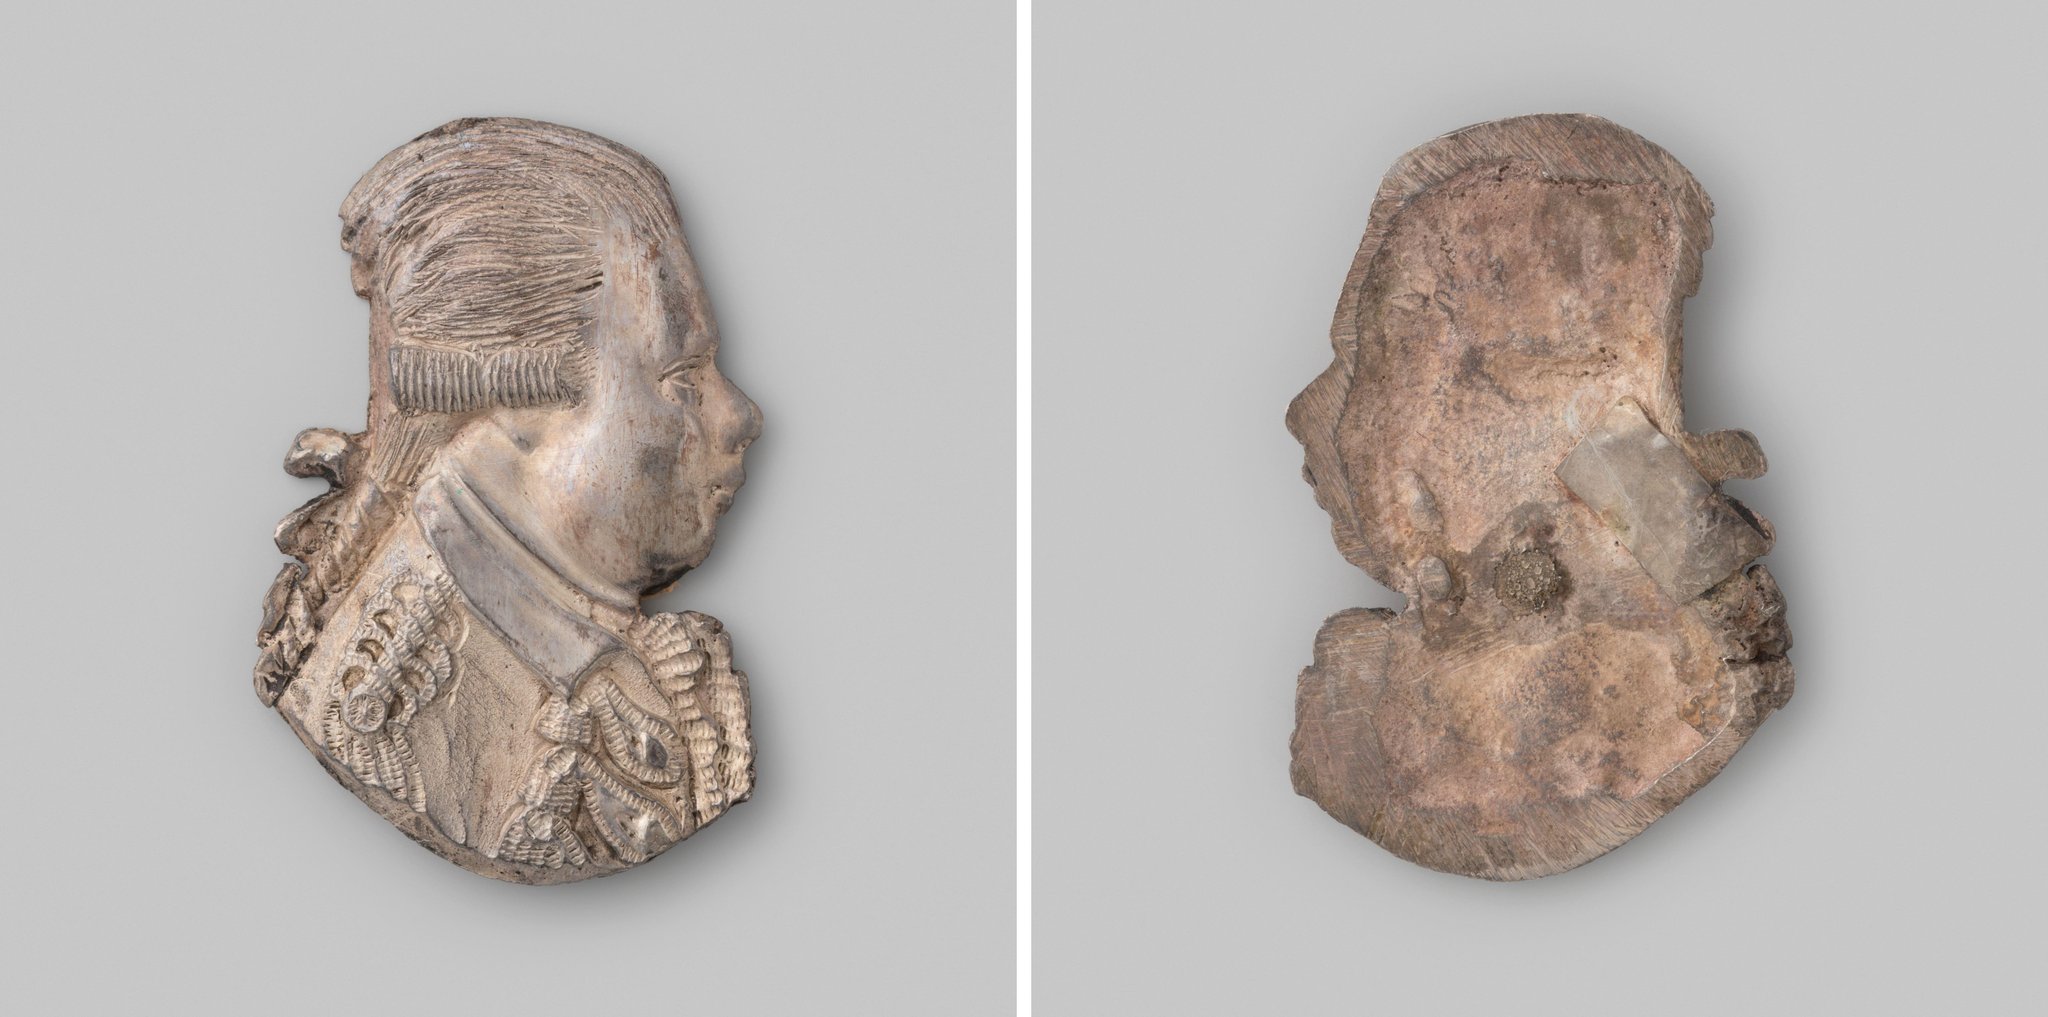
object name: insignia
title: Willem V, prins van Oranje-Nassau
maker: Anonymous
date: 1787-1795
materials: silver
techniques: casting, welding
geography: netherlands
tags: the hague, william v (prince of orange)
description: Eenzijdig zilveren draagteken in vorm van mannenbuste. Voorzijde: borststuk man. Keerzijde: blanco